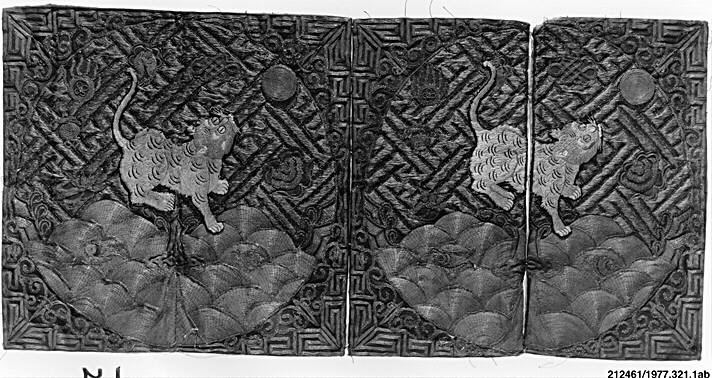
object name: rank badge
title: Rank Badge with Tiger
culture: chinese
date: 1867-1900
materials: gold, silk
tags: tigers